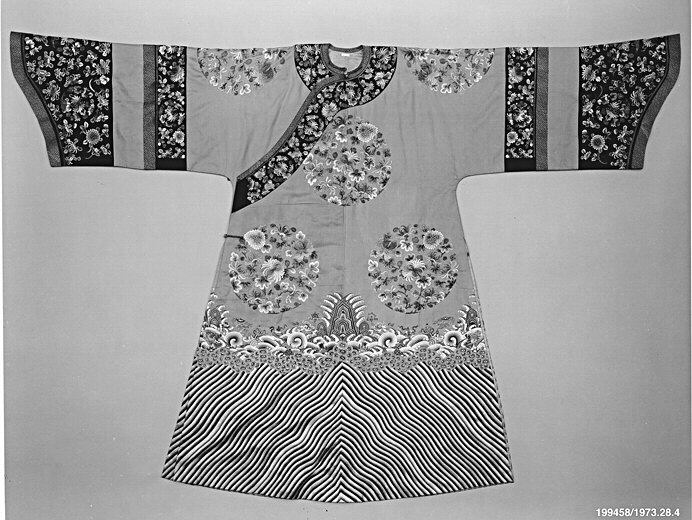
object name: woman's ceremonial robe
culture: chinese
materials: metal thread, silk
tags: flowers